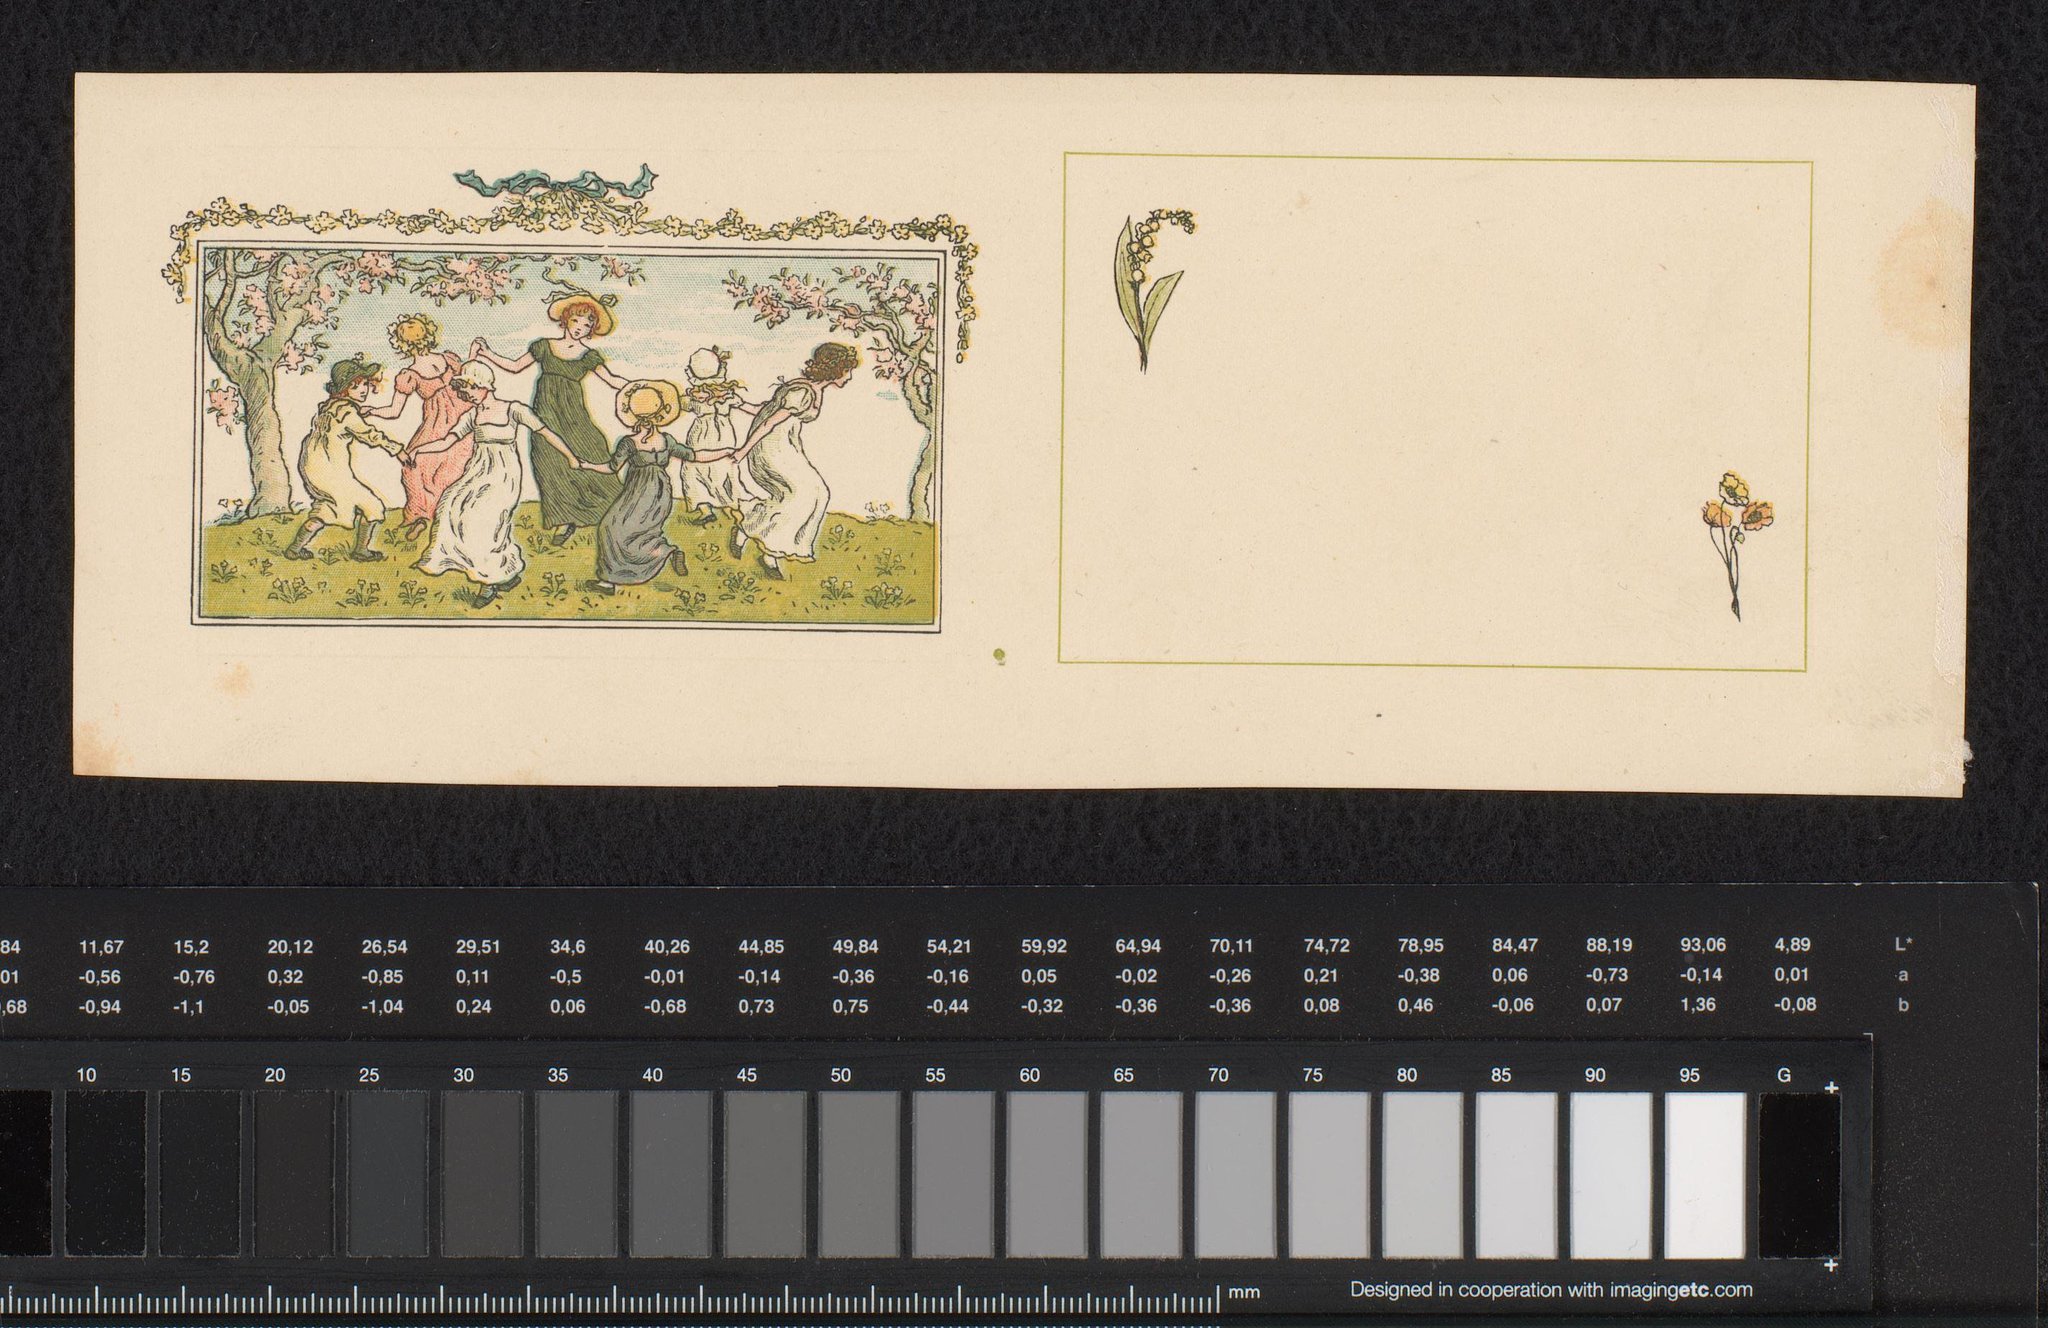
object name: print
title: Vijf proefdrukken voor de Almanack for 1887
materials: paper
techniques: wood engraving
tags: flowers, group of women (folk dancing)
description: Proefdrukken, vóór de letter, van vier bladzijden uit de almanak. Een lege bladzijde, twee met kleine bloemvignetten, en een rondedans van meisjes.